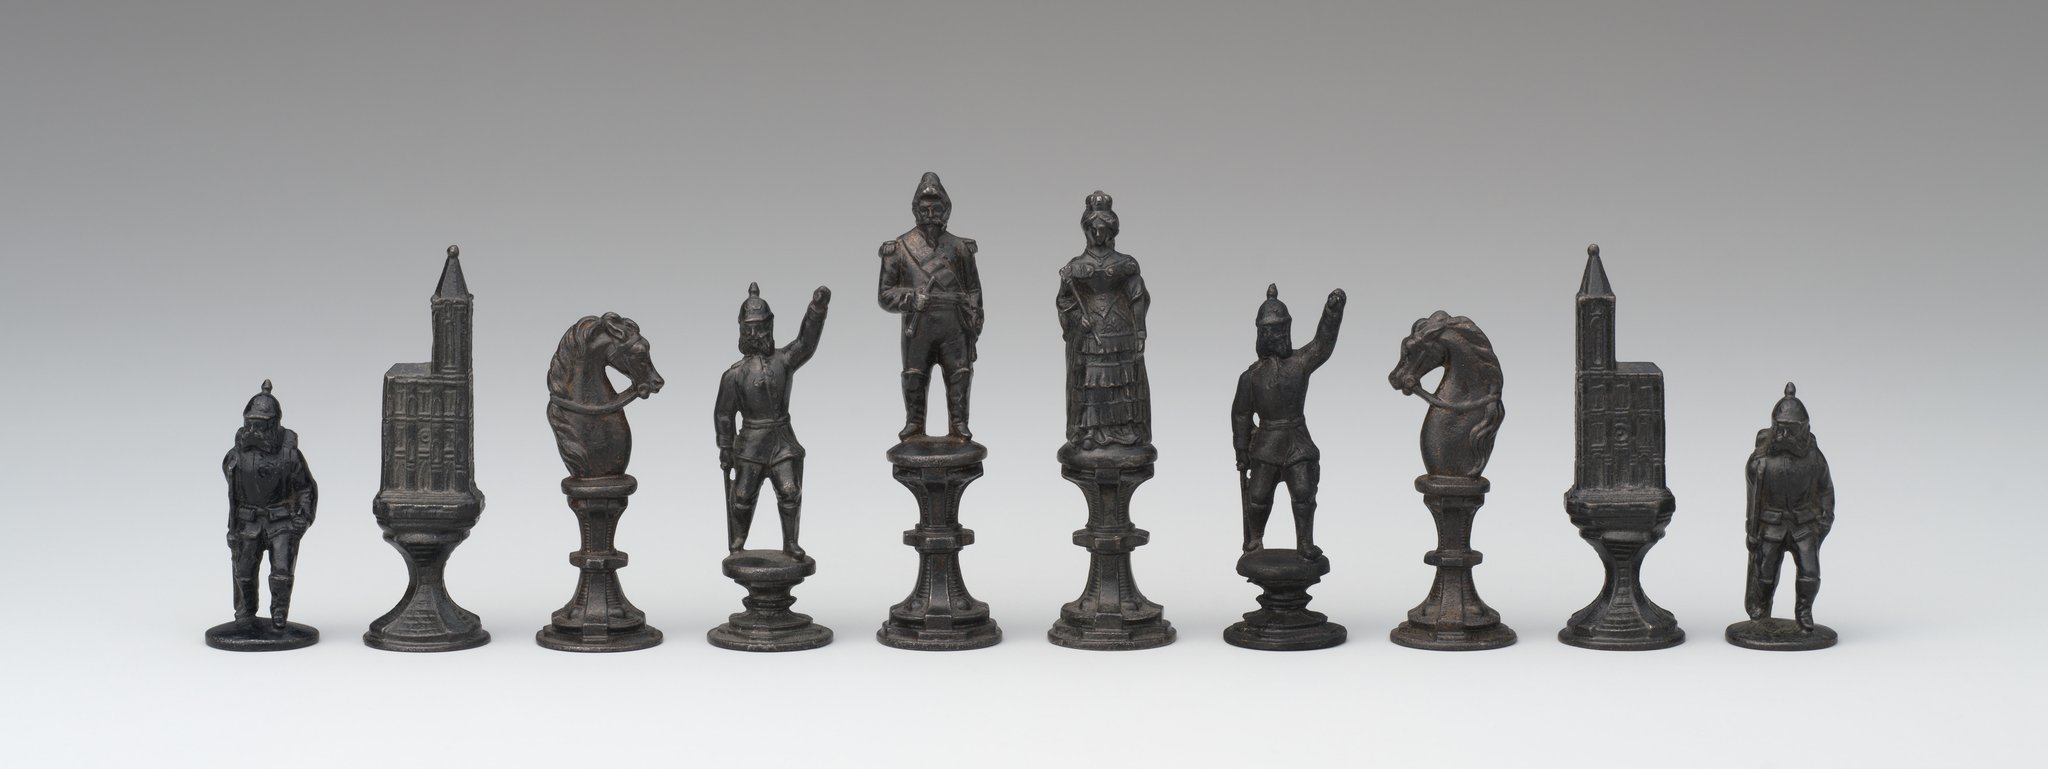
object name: chessman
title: Chessmen (32)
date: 1801-1900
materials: iron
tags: chess,games